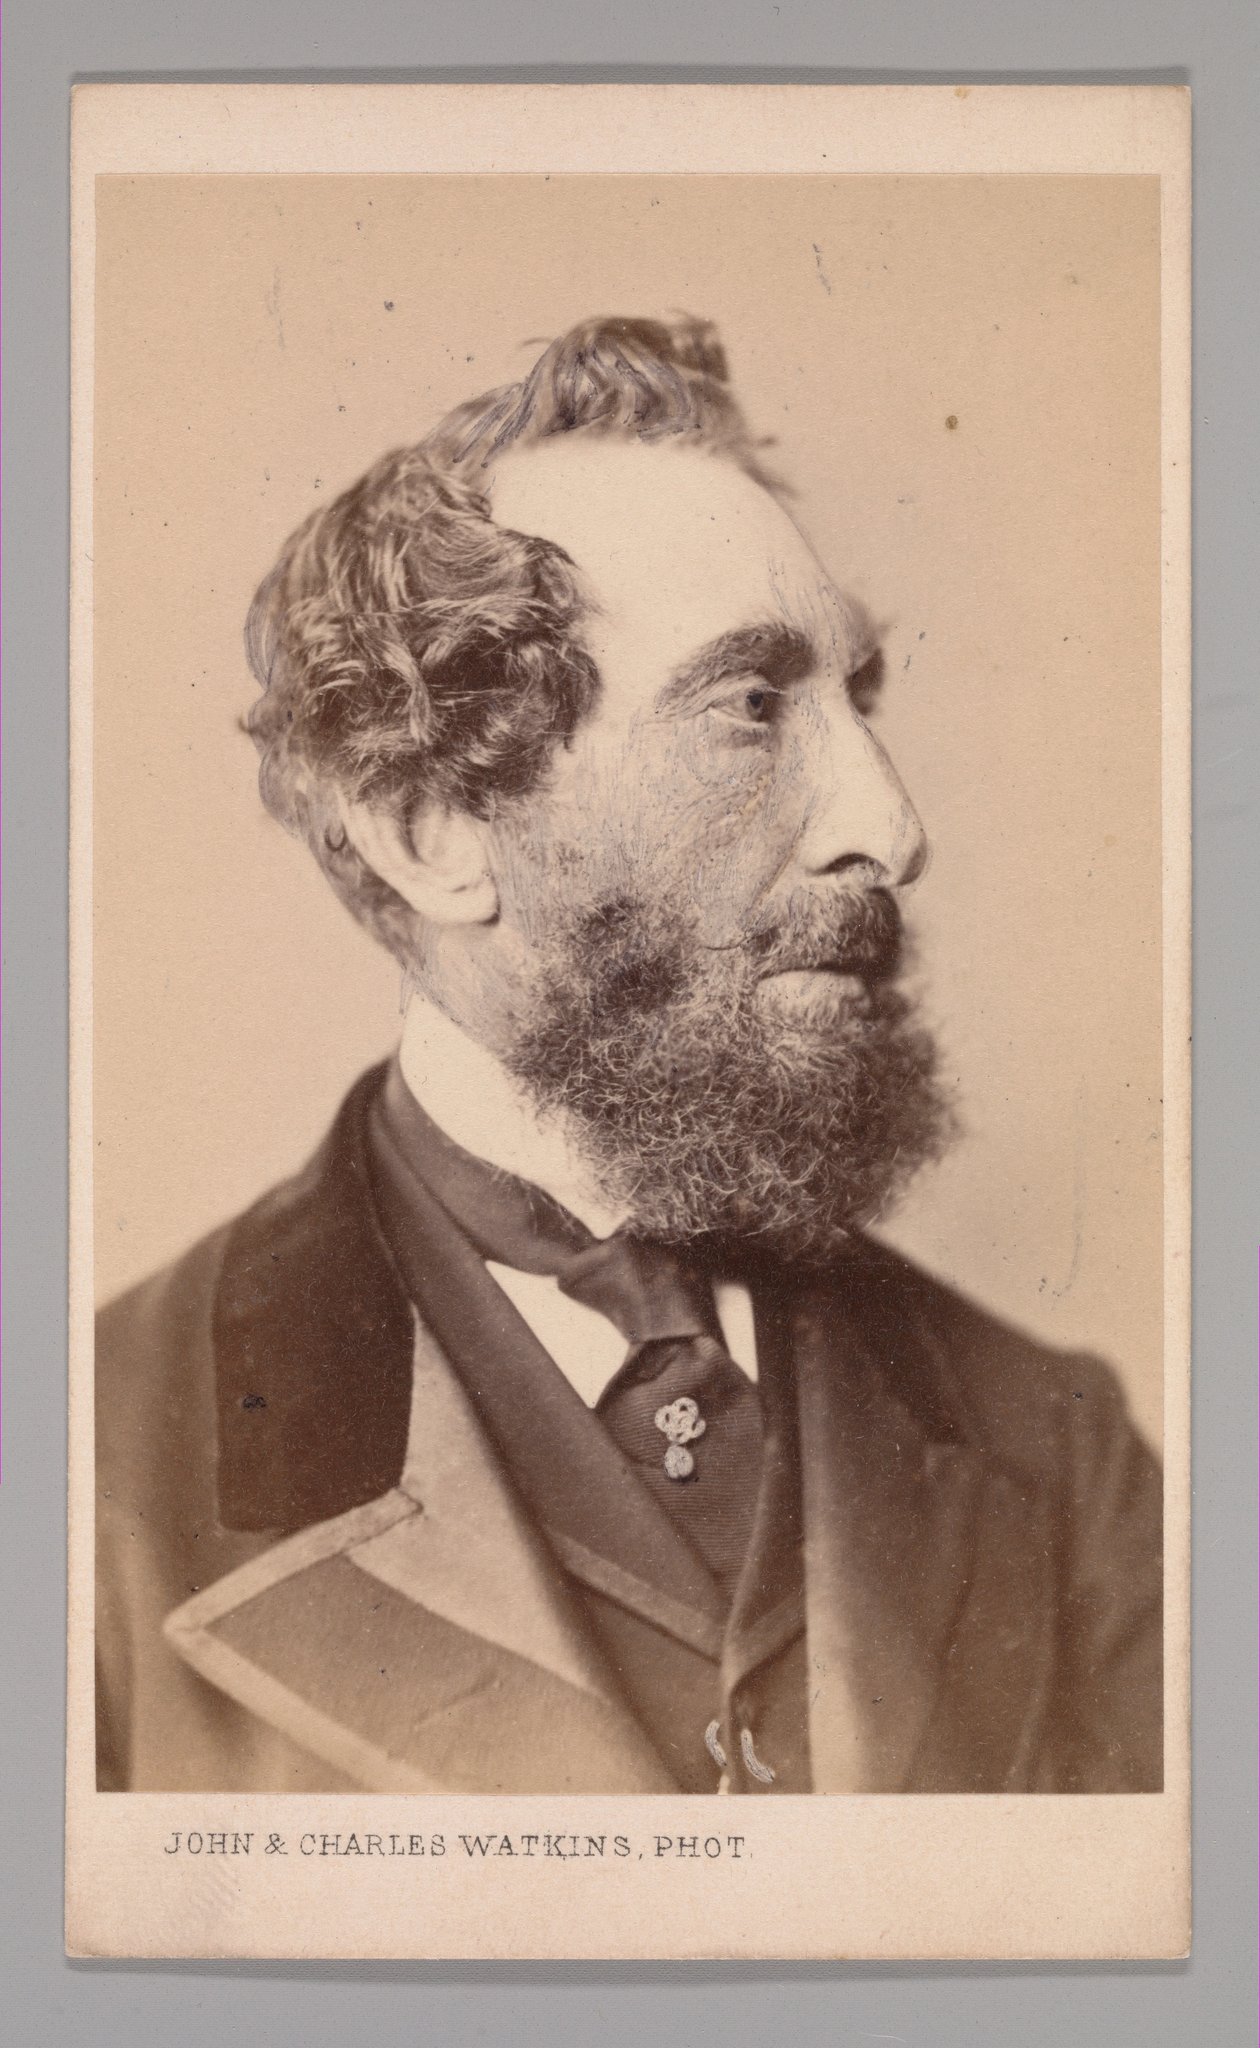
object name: carte de visite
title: [Unknown Subject]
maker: john and charles watkins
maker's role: photography studio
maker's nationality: british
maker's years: 1840-1875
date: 1860-1869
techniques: albumen silver print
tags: men,portraits,profiles